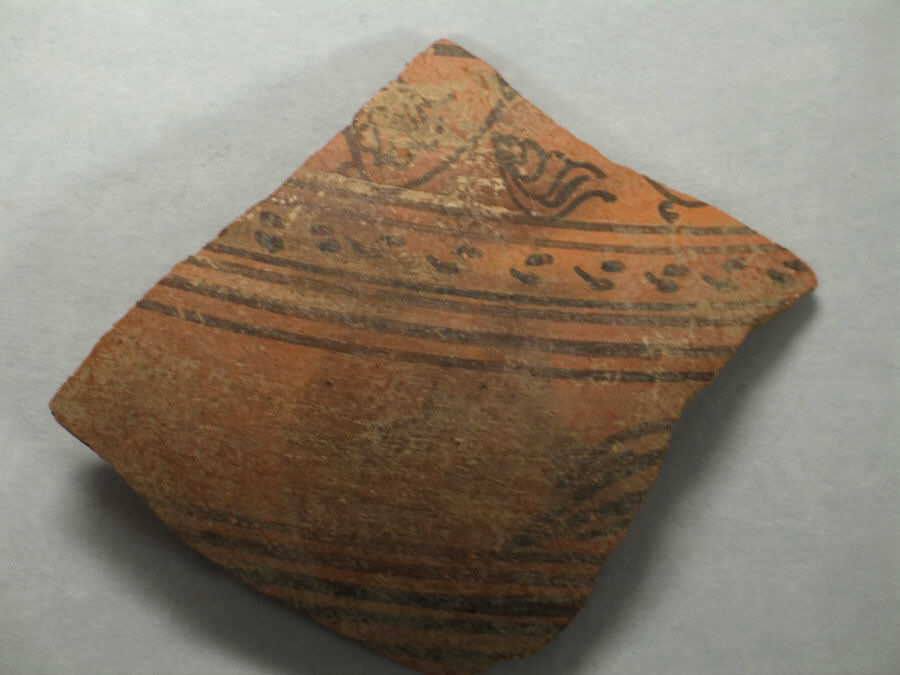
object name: shard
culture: pakistani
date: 301-500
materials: terracotta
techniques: painting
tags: gandhara